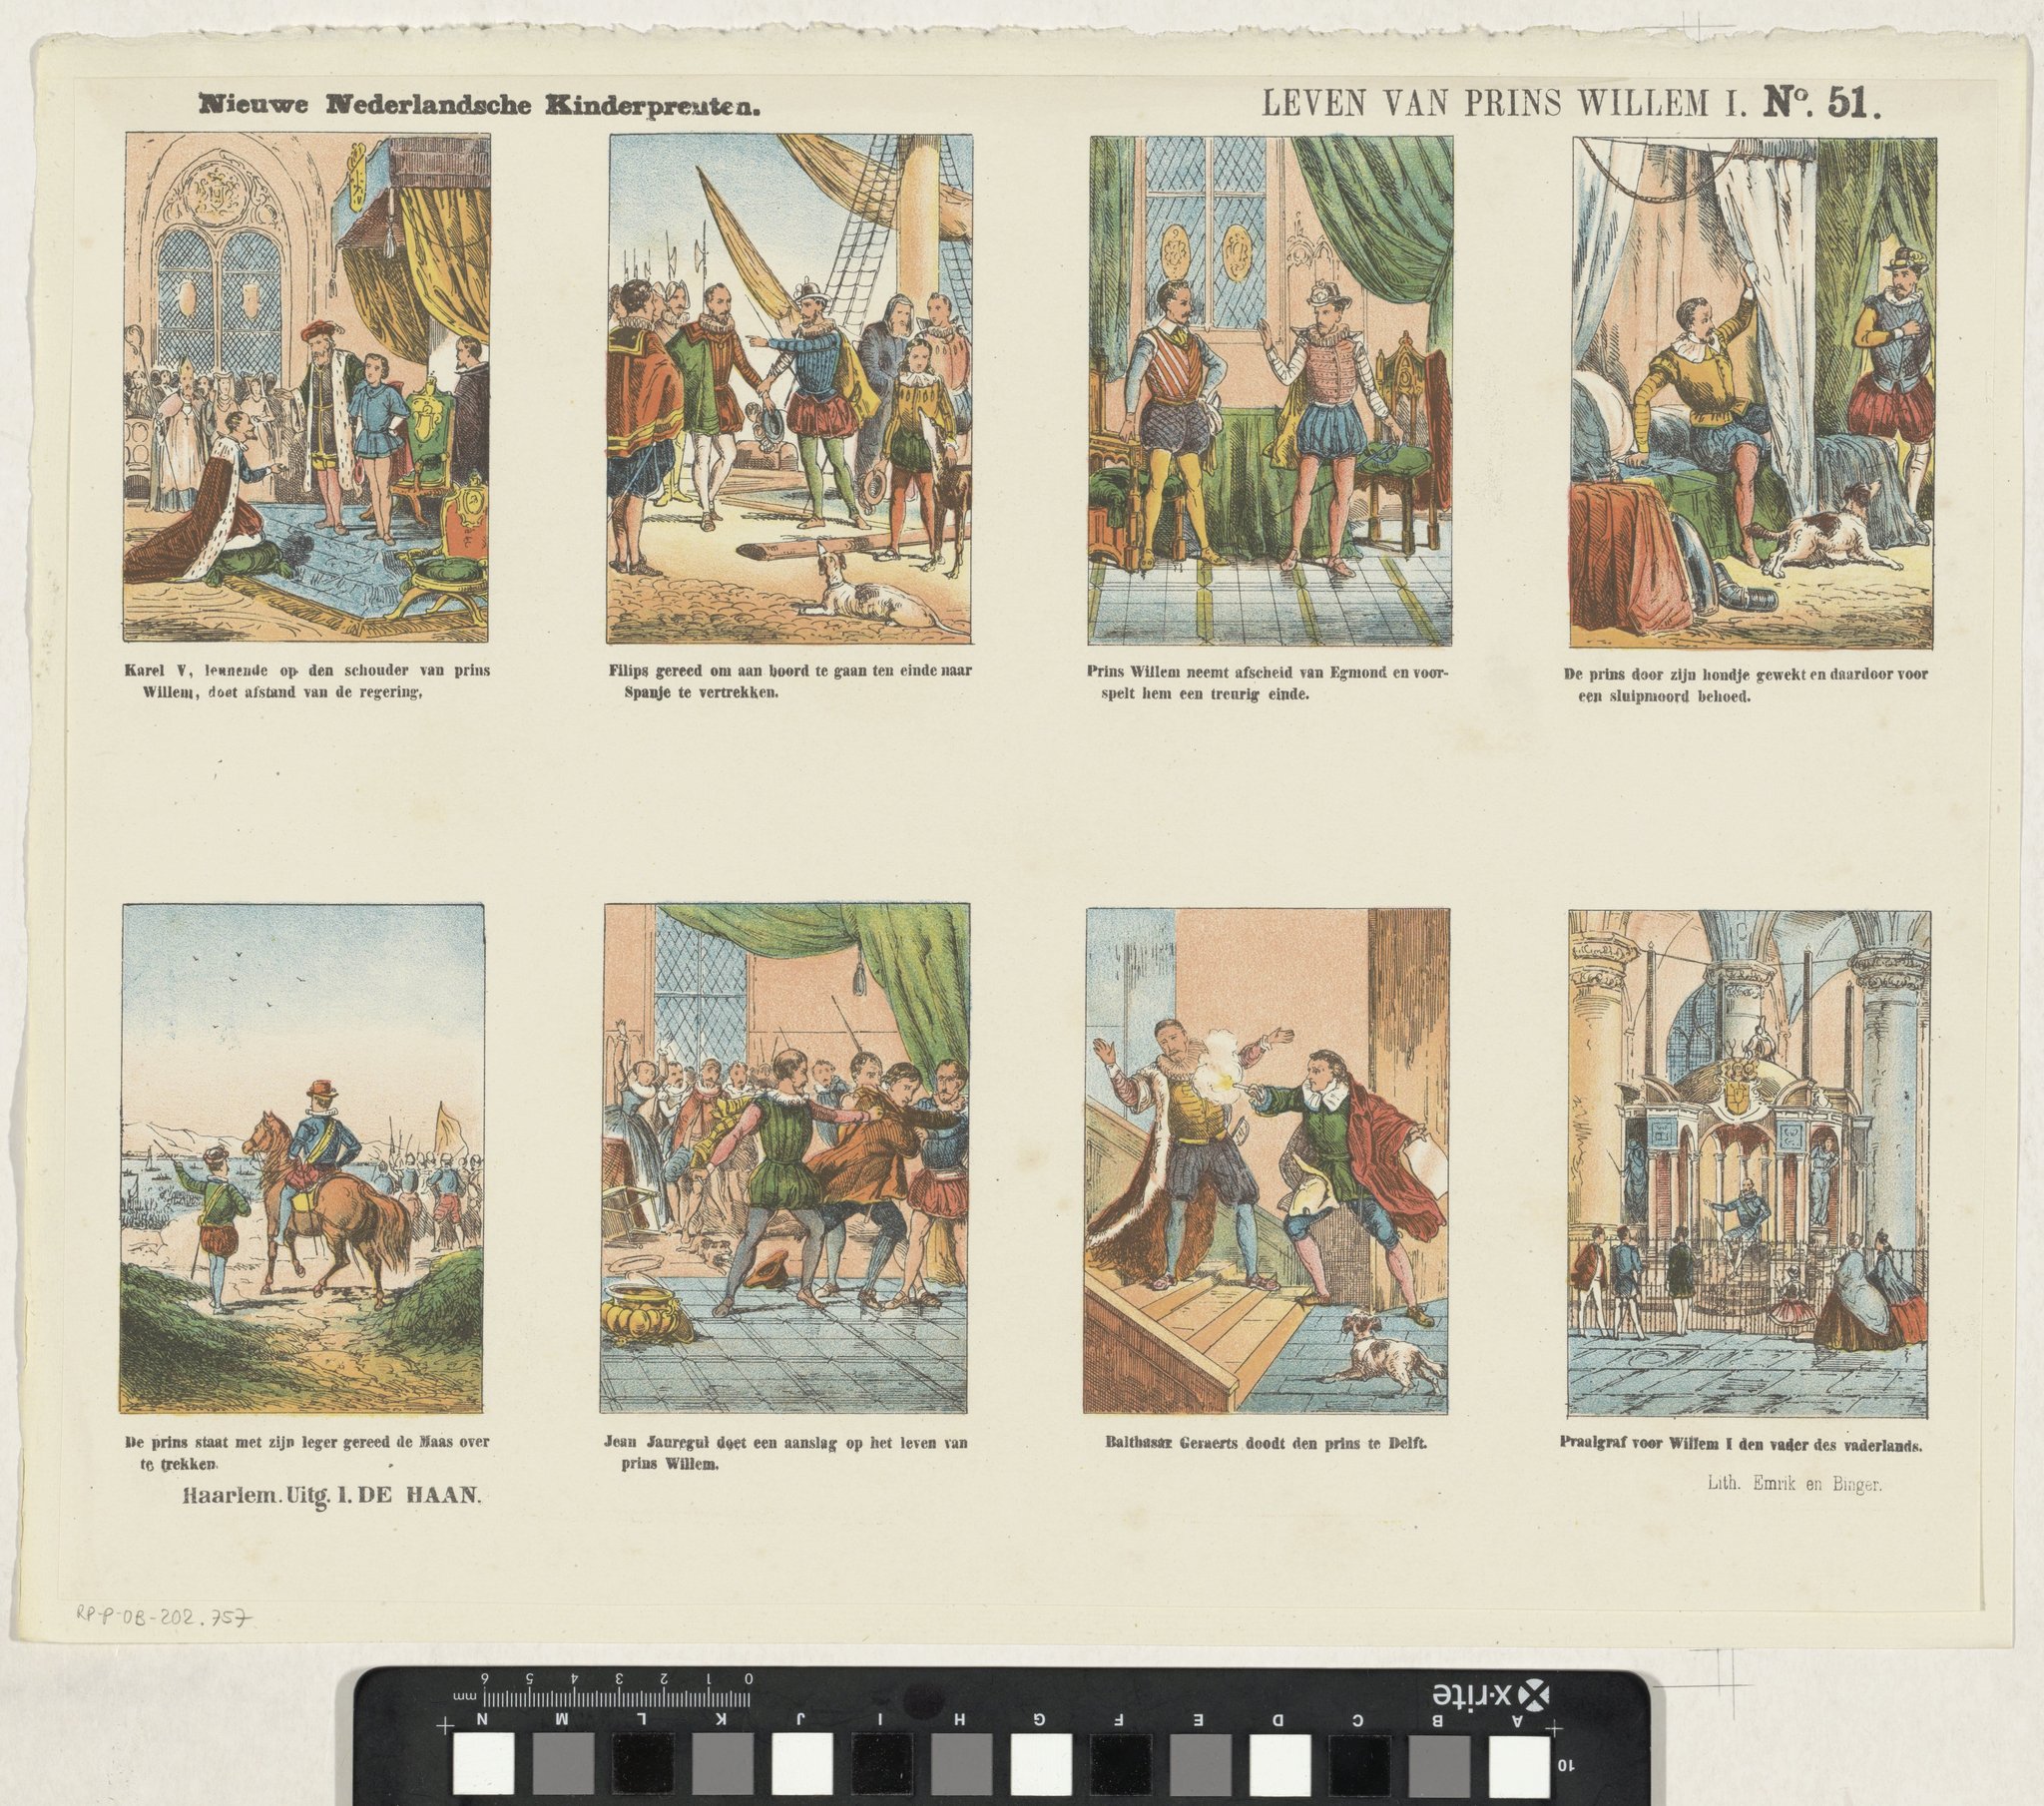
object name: print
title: Nieuwe Nederlandsche kinderprenten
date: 1875-1903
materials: paper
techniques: lithograph, letterpress printing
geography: haarlem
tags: philip ii of spain, delft, william i (prince of orange), ghent, charles v (holy roman emperor and king of spain)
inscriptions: collector's mark: Lugt 2760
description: Blad met 8 voorstellingen over het leven van Willem I. Onder elke afbeelding een tweeregelig vers. Genummerd rechtsboven: No. 51.